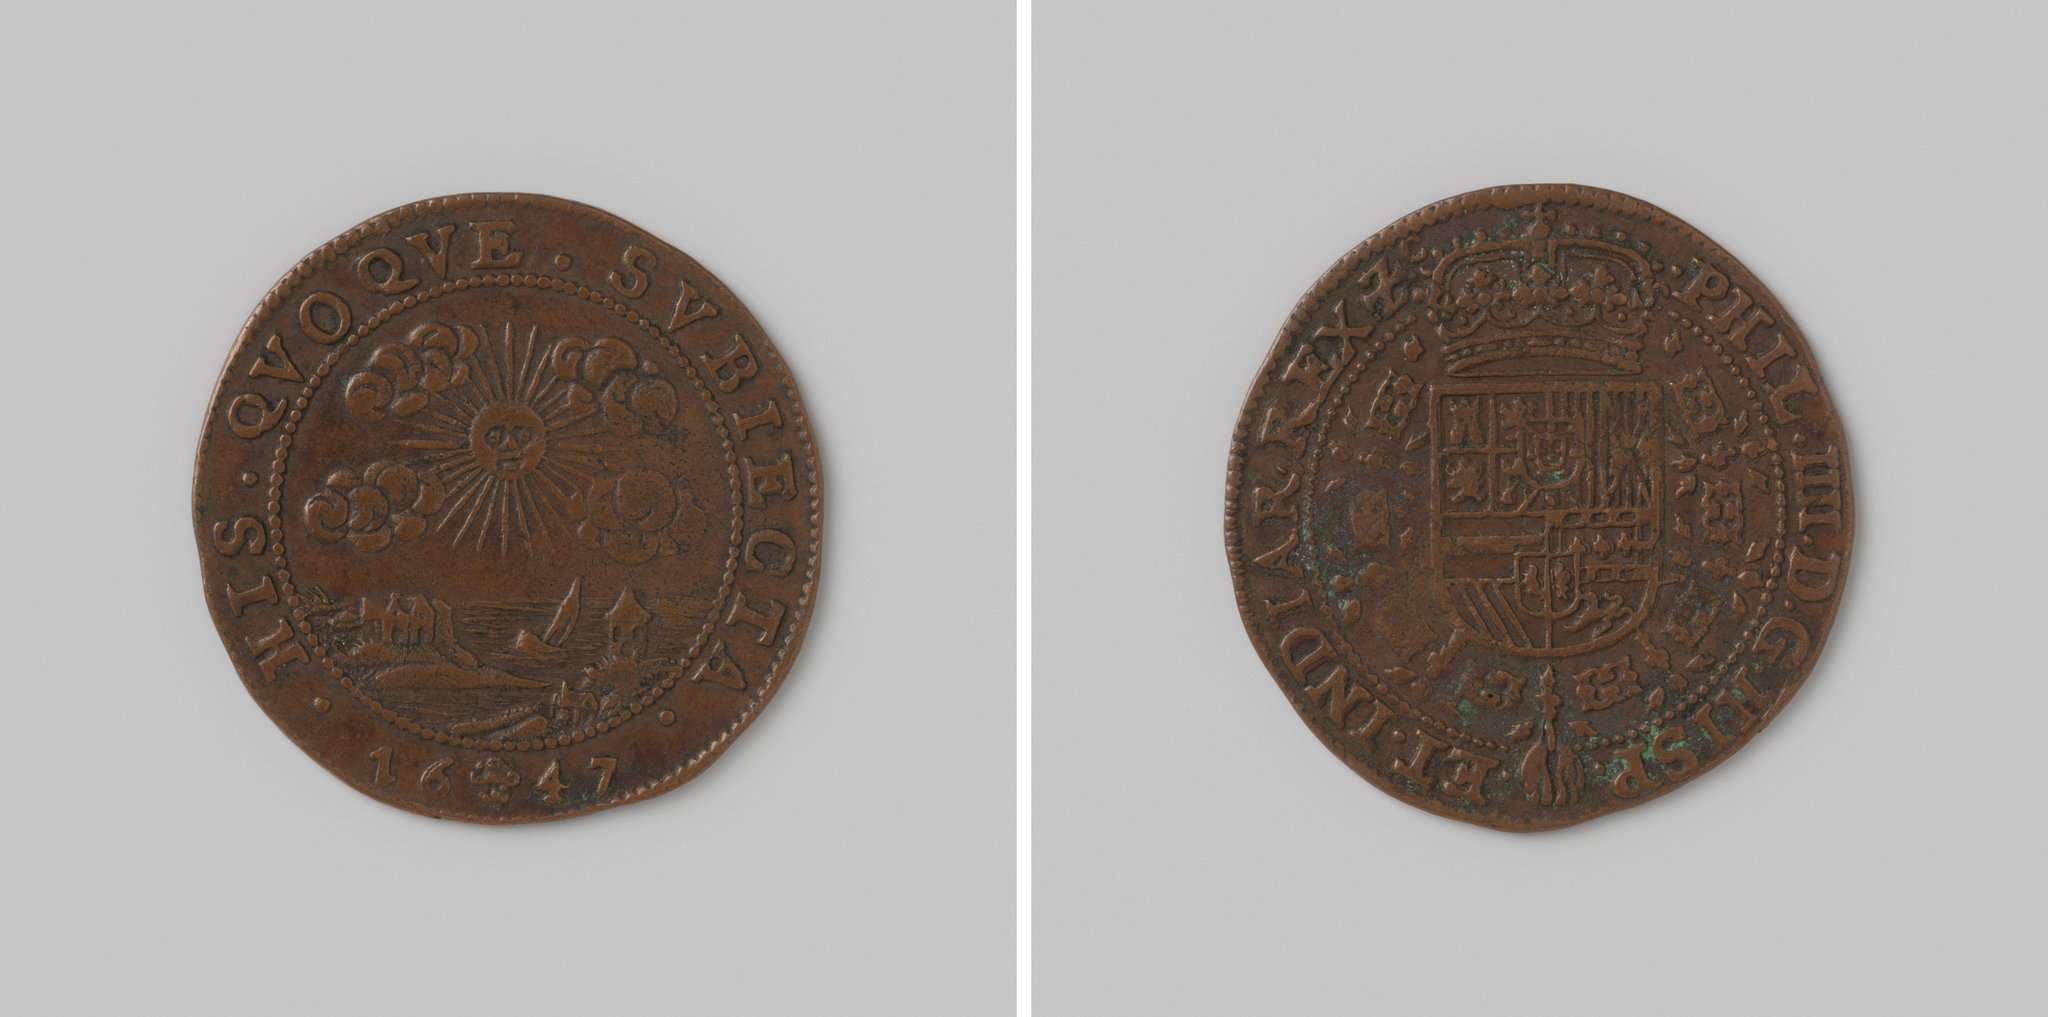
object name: history medal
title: Rekenpenning uit Brussel 1647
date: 1647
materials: copper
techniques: striking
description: Koperen penning, op de voorzijde een kustlandschap waarboven de zon door de wolken komt, met omschrift, op de keerzijde het gekroonde Spaanse wapenschild omhangen met de keten van het Gulden Vlies, met omschrift.